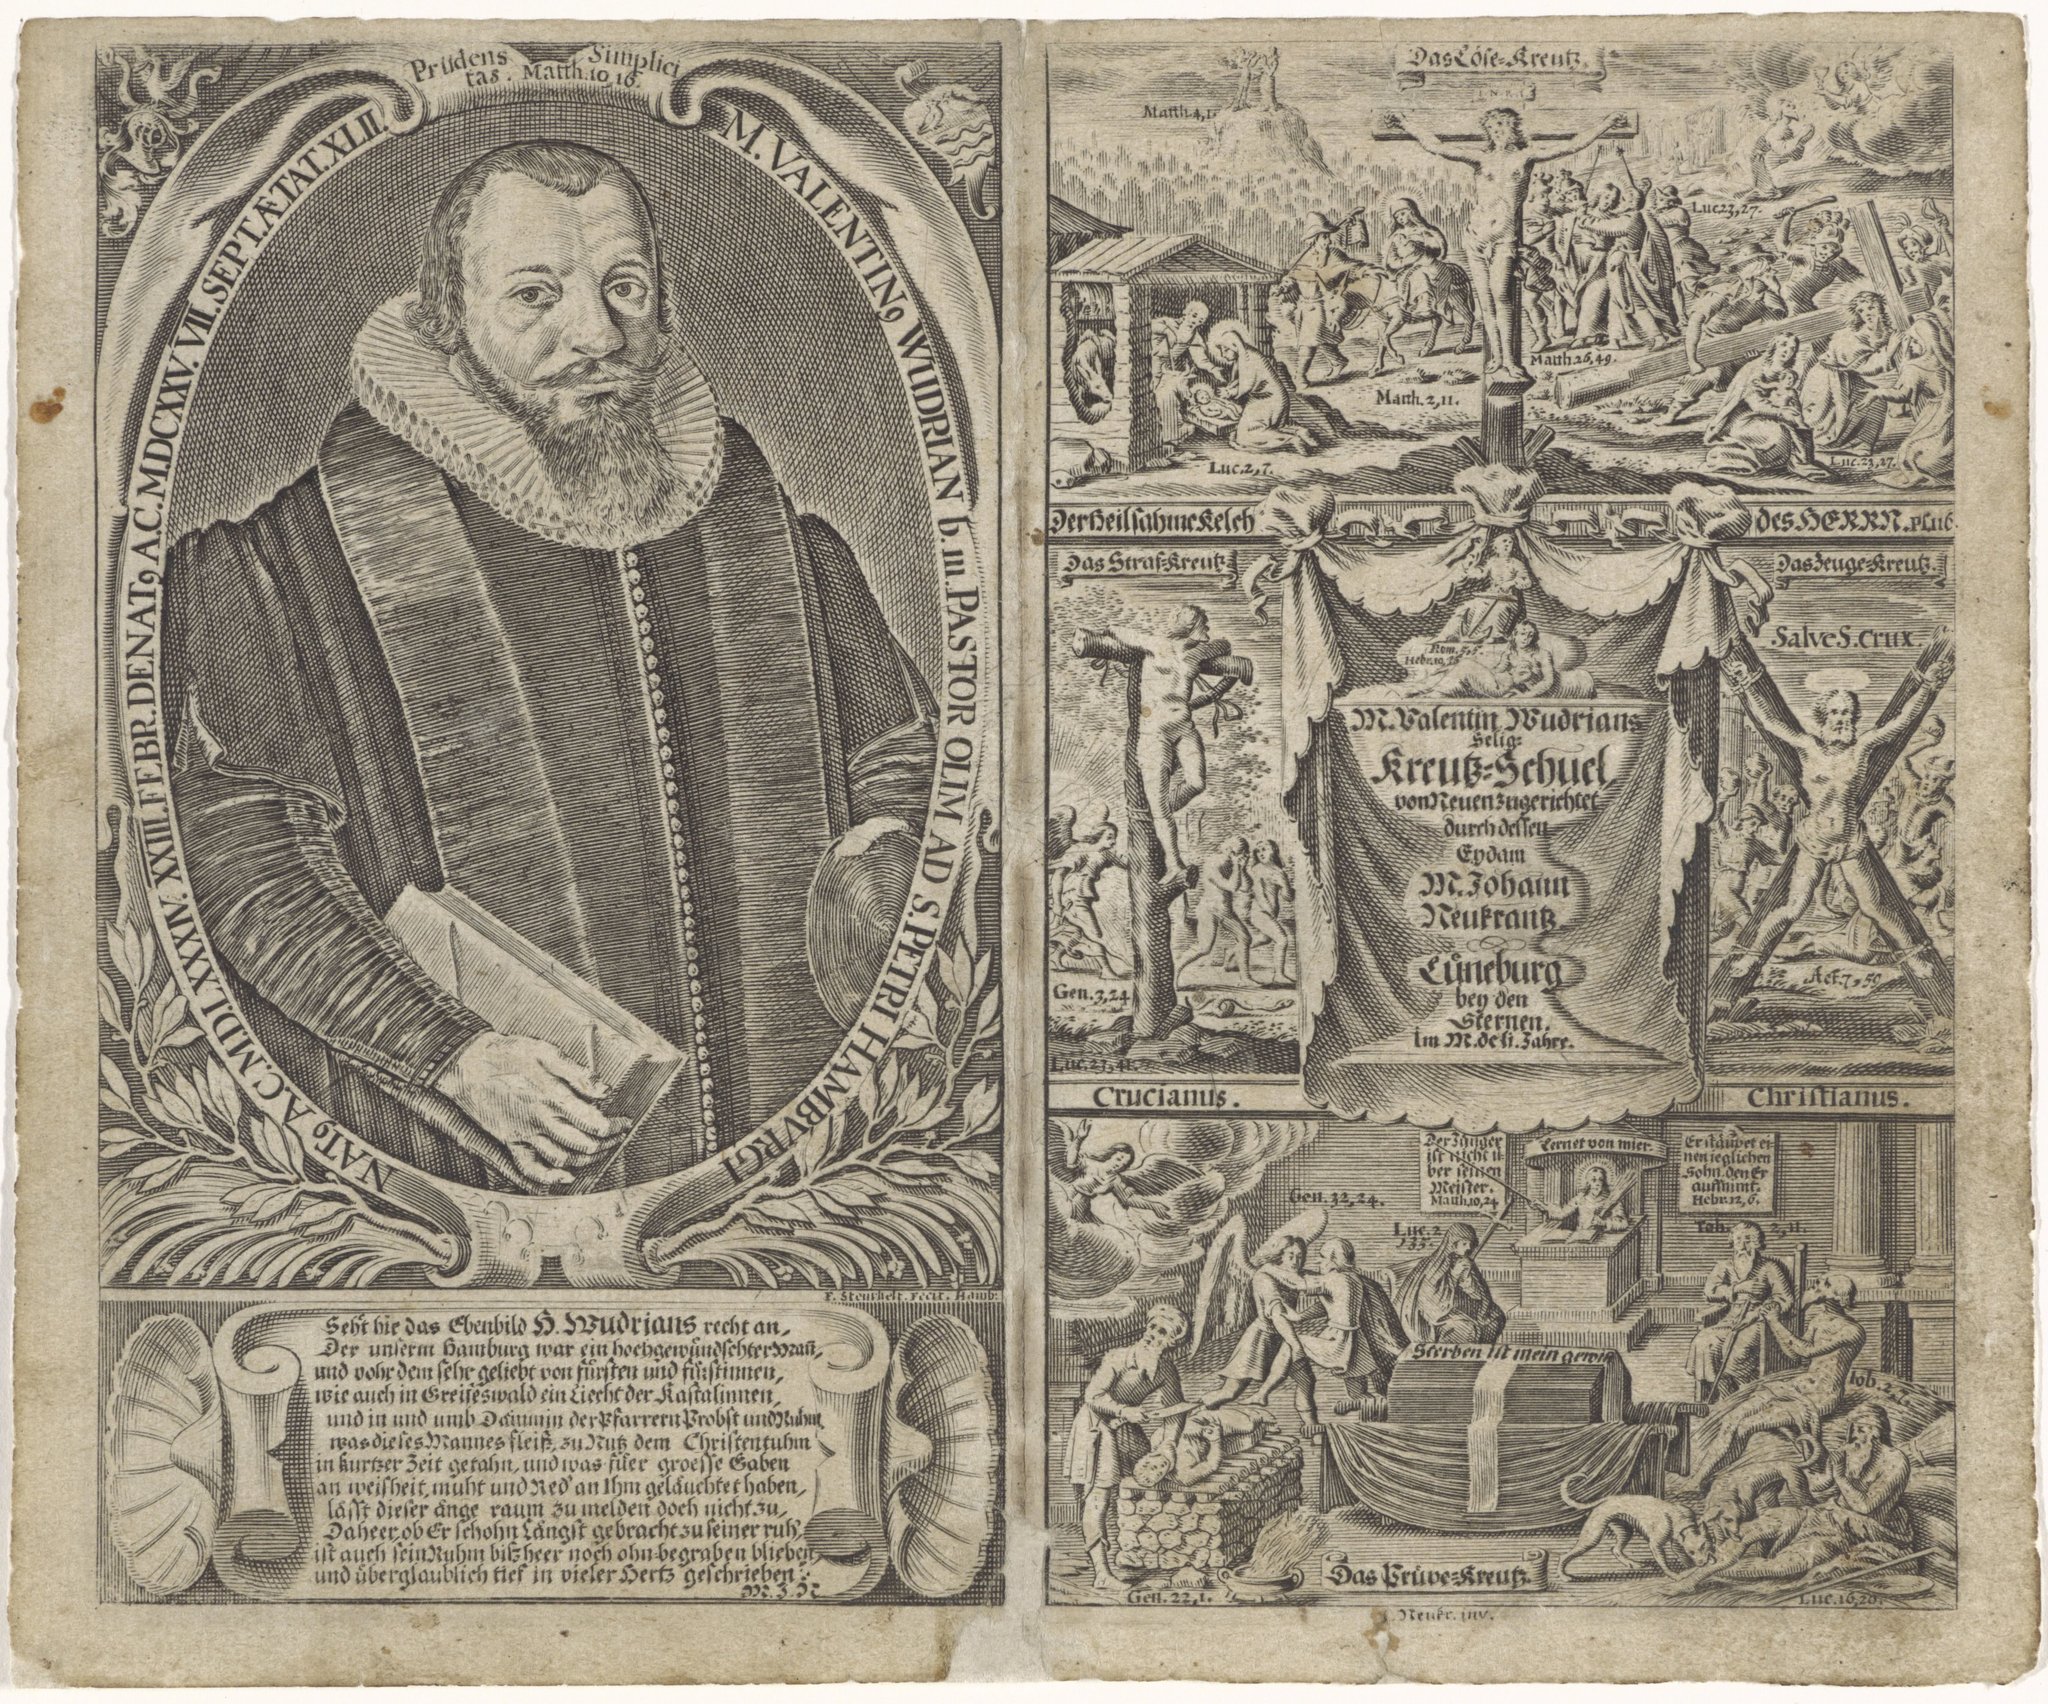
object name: titelblad, titelpagina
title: Titelpagina voor: Valentin Wudrian, Schola crucis et tessera Christianismi. Creutz-Schule und Kennzeichen aller wahren Evangelischen Christen, oder Christlicher ausführlicher und nützlicher Unterricht vom lieben Creutze, 1651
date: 1651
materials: paper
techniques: engraving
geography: hamburg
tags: theologian, the cross ~ symbols of christ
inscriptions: collector's mark: Lugt 2228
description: Links het portret van theoloog Valentin Wudrian met een boek onder de arm. Onder het portret een cartouche met een tekst in het Duits. Rechts de titelpagina voor een van zijn boeken over het kruis van Christus. Daarbij afbeeldingen van de kruisiging van Christus en verschillende voorstellingen uit het Oude en Nieuwe Testament.